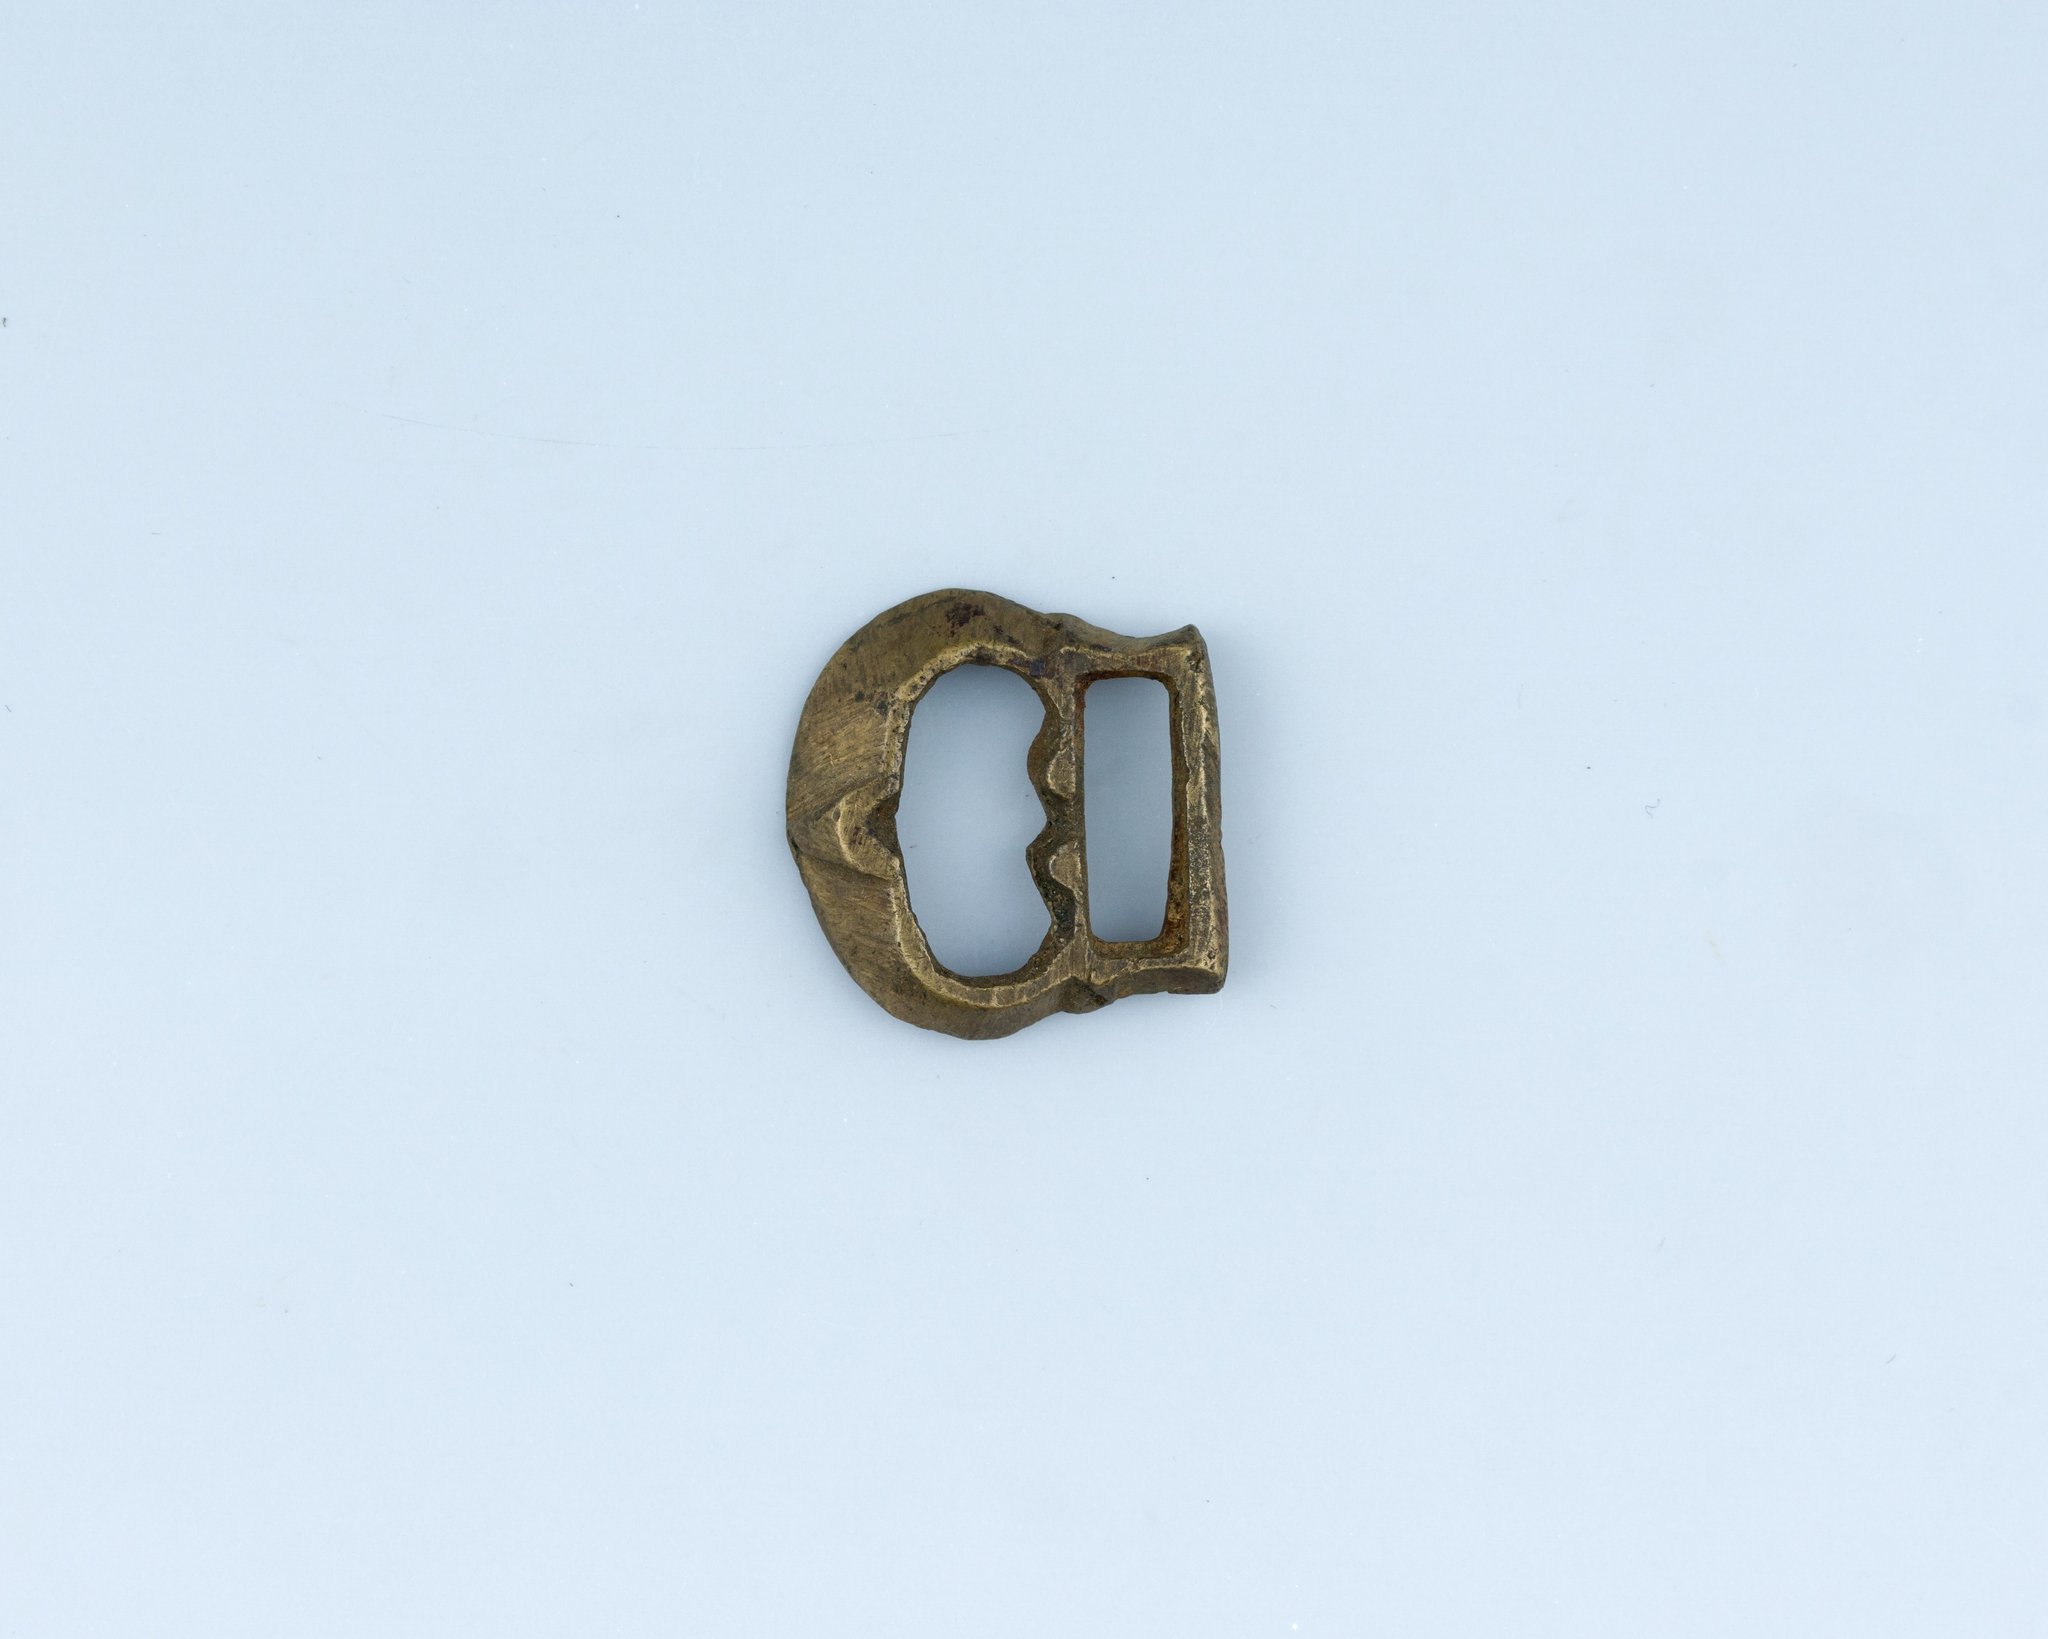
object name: buckle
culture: european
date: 1401-1700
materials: brass